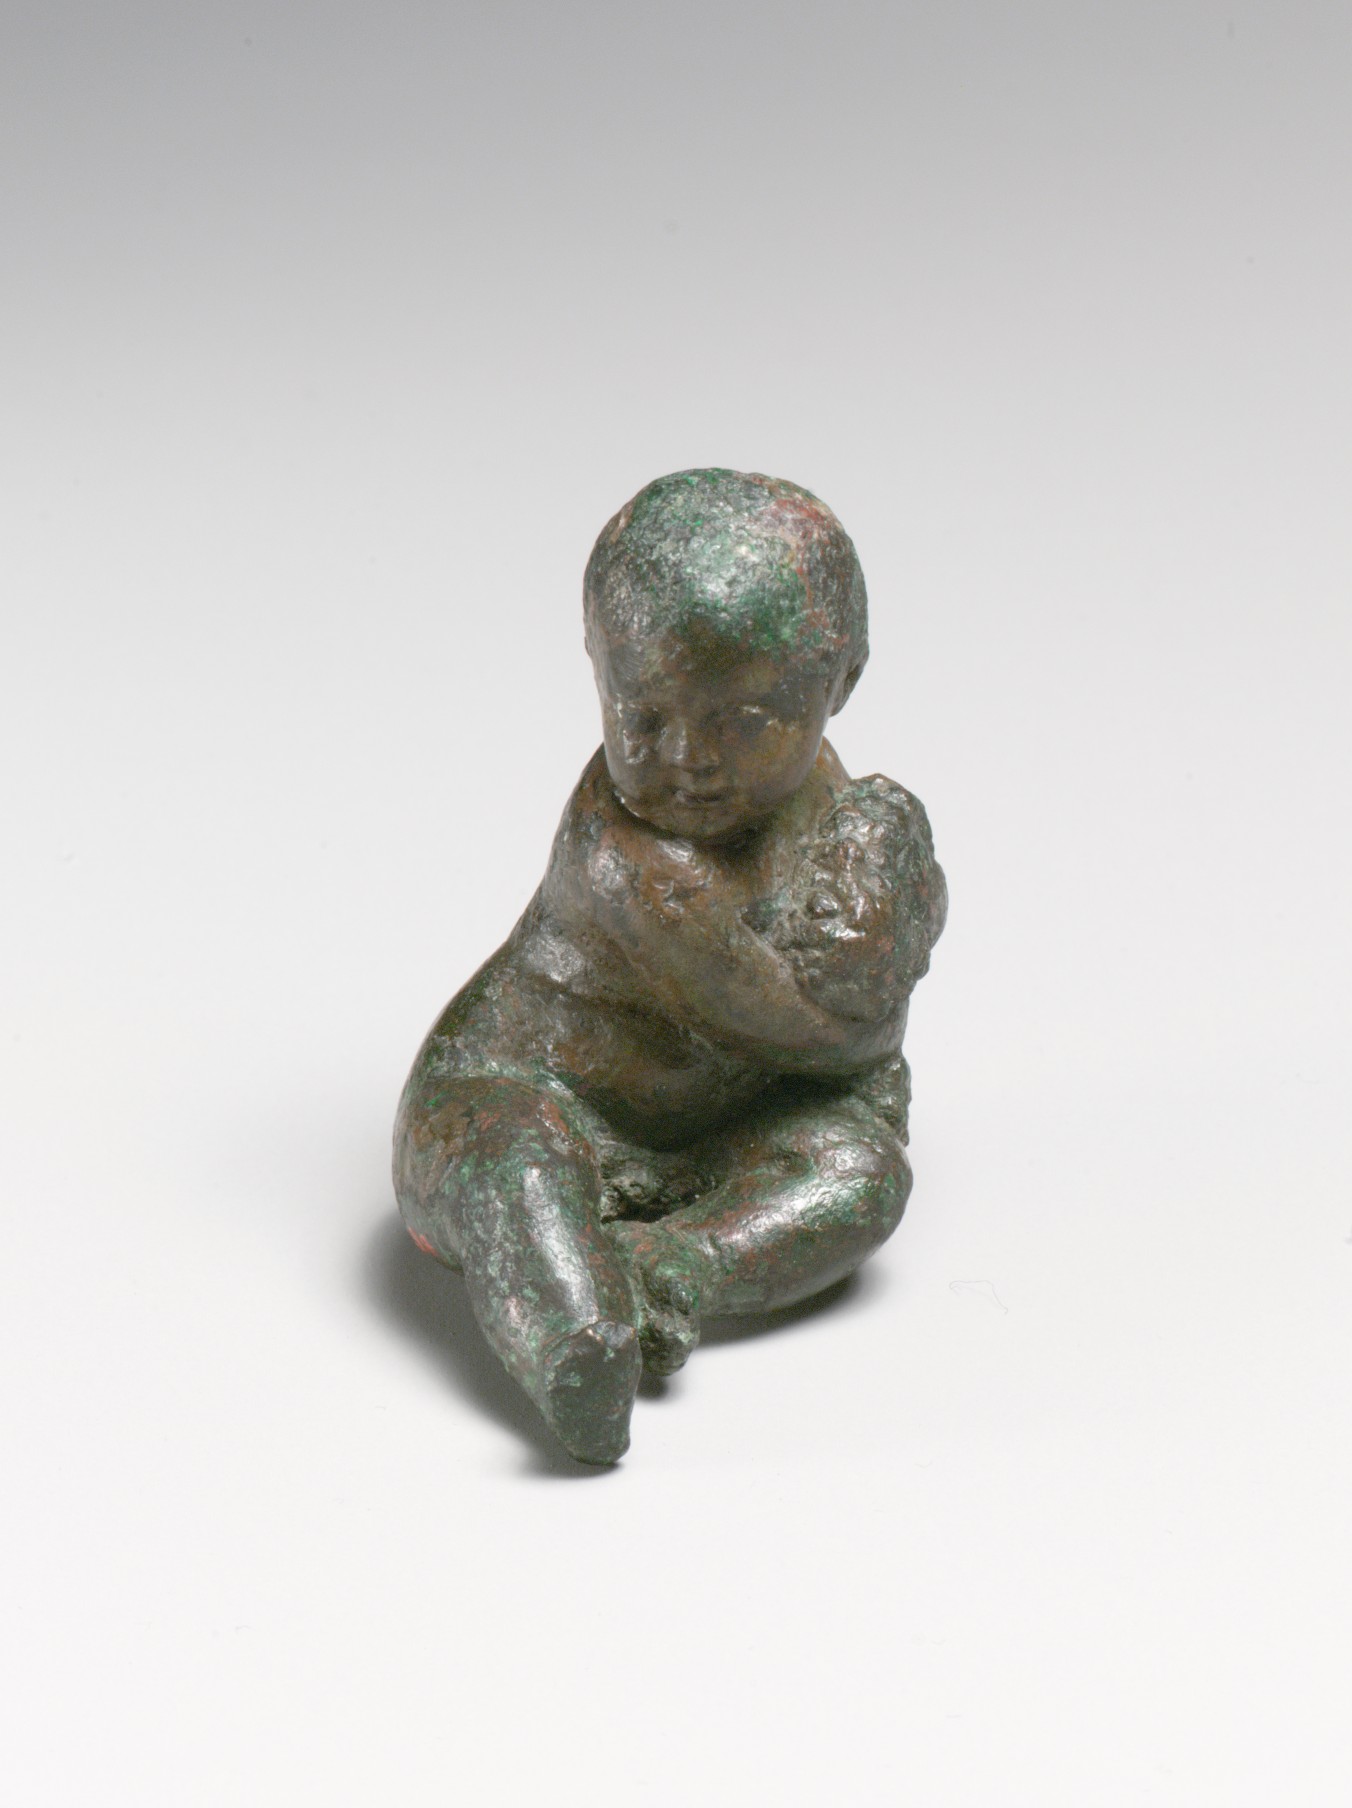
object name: statuette of a boy with a bunch of grape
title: Bronze statuette of a child with a bunch of grapes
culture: roman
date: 1-200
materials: bronze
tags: grapes,children